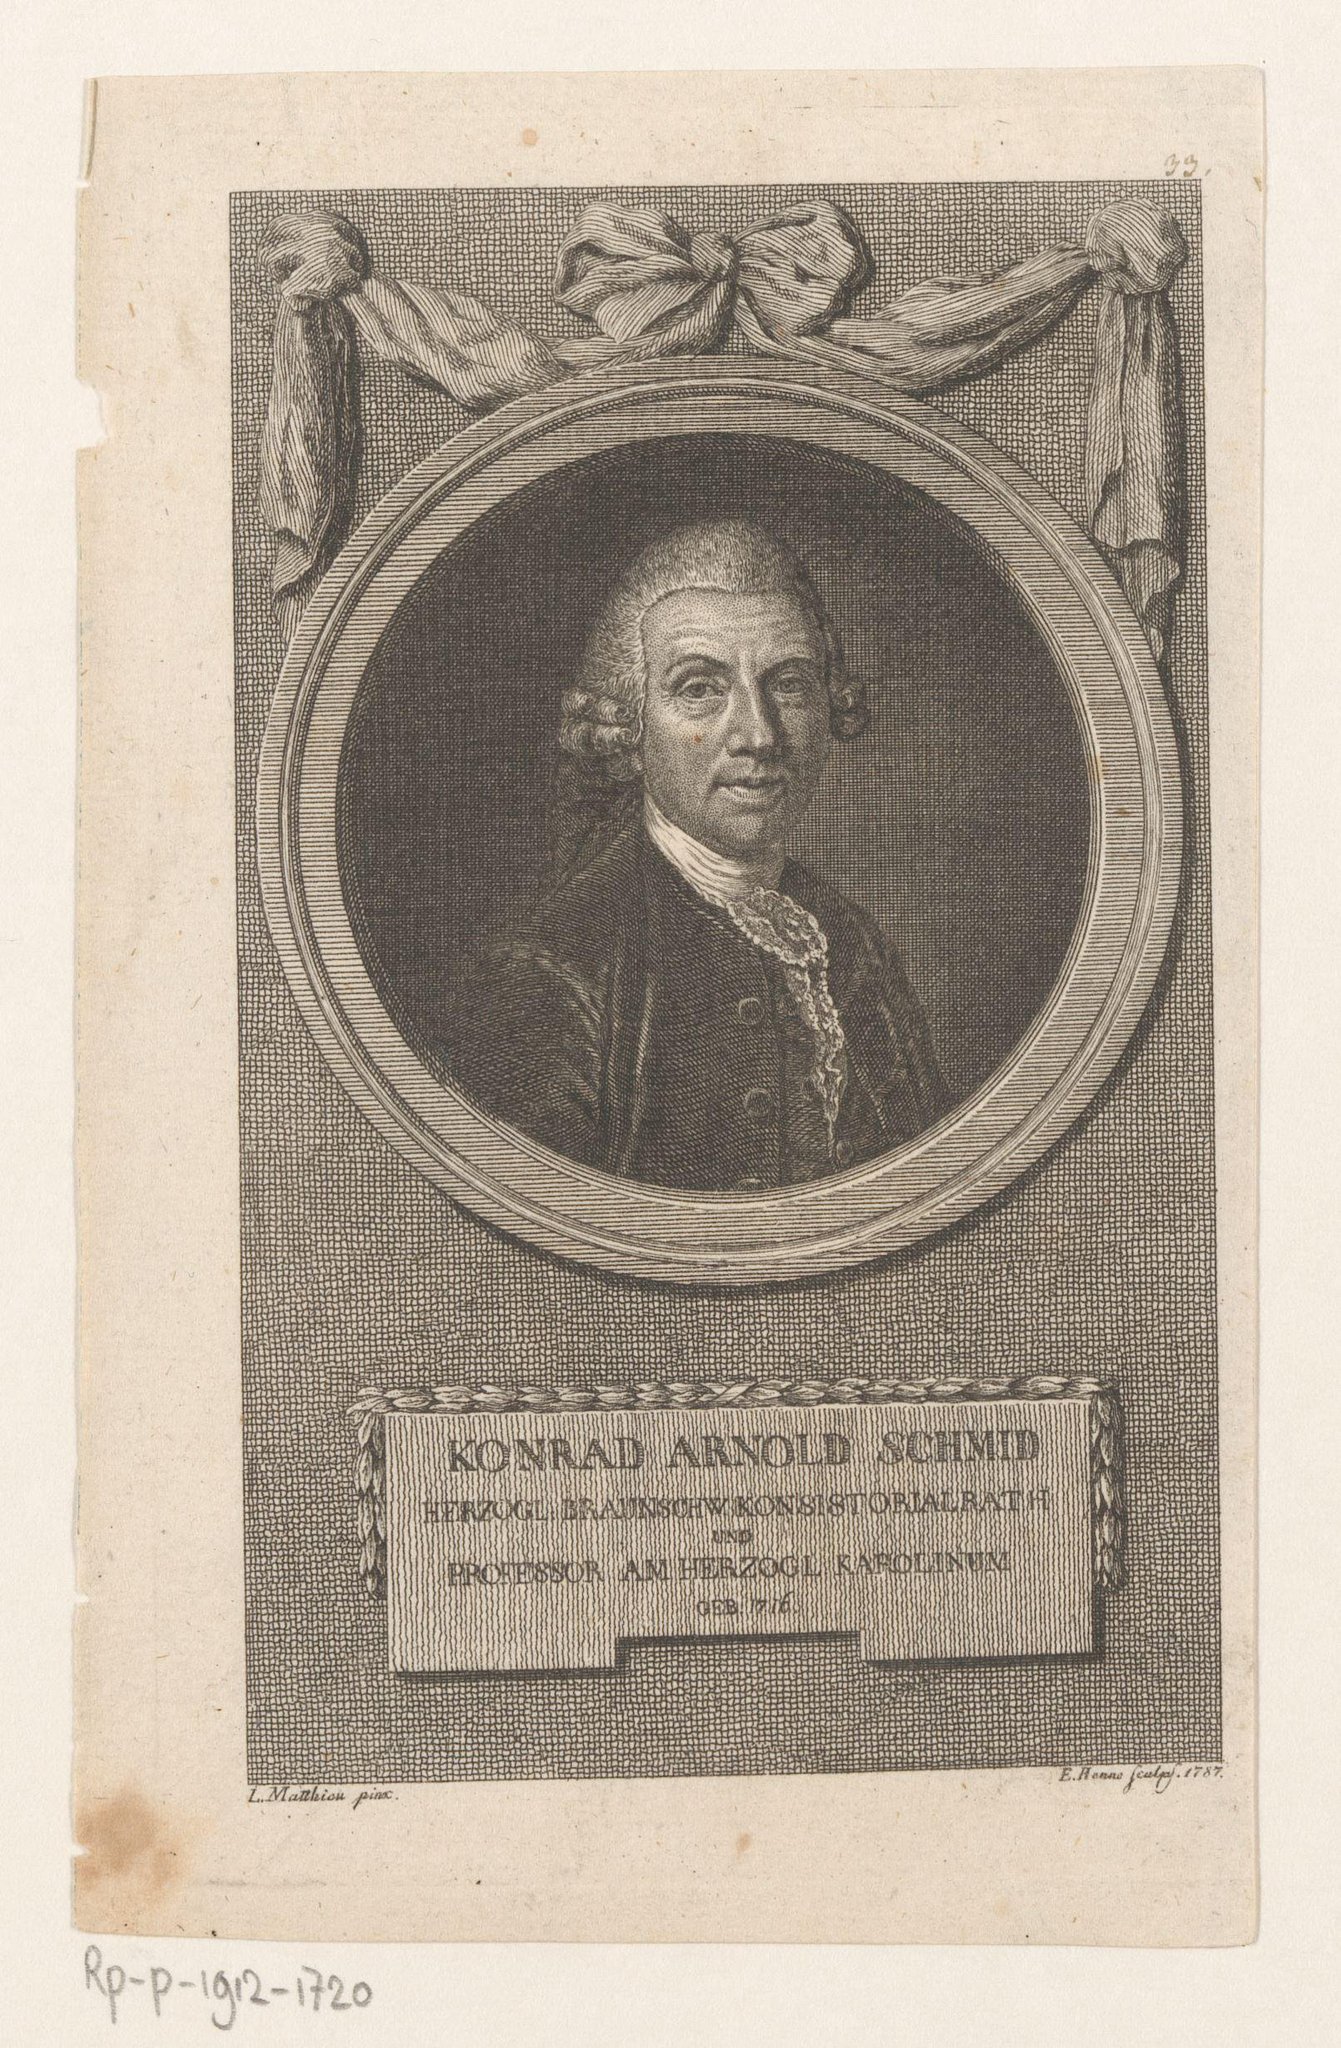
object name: print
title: Portret van Konrad Arnold Schmid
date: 1787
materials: paper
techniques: engraving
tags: theologian, historical persons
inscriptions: collector's mark: Lugt 2228